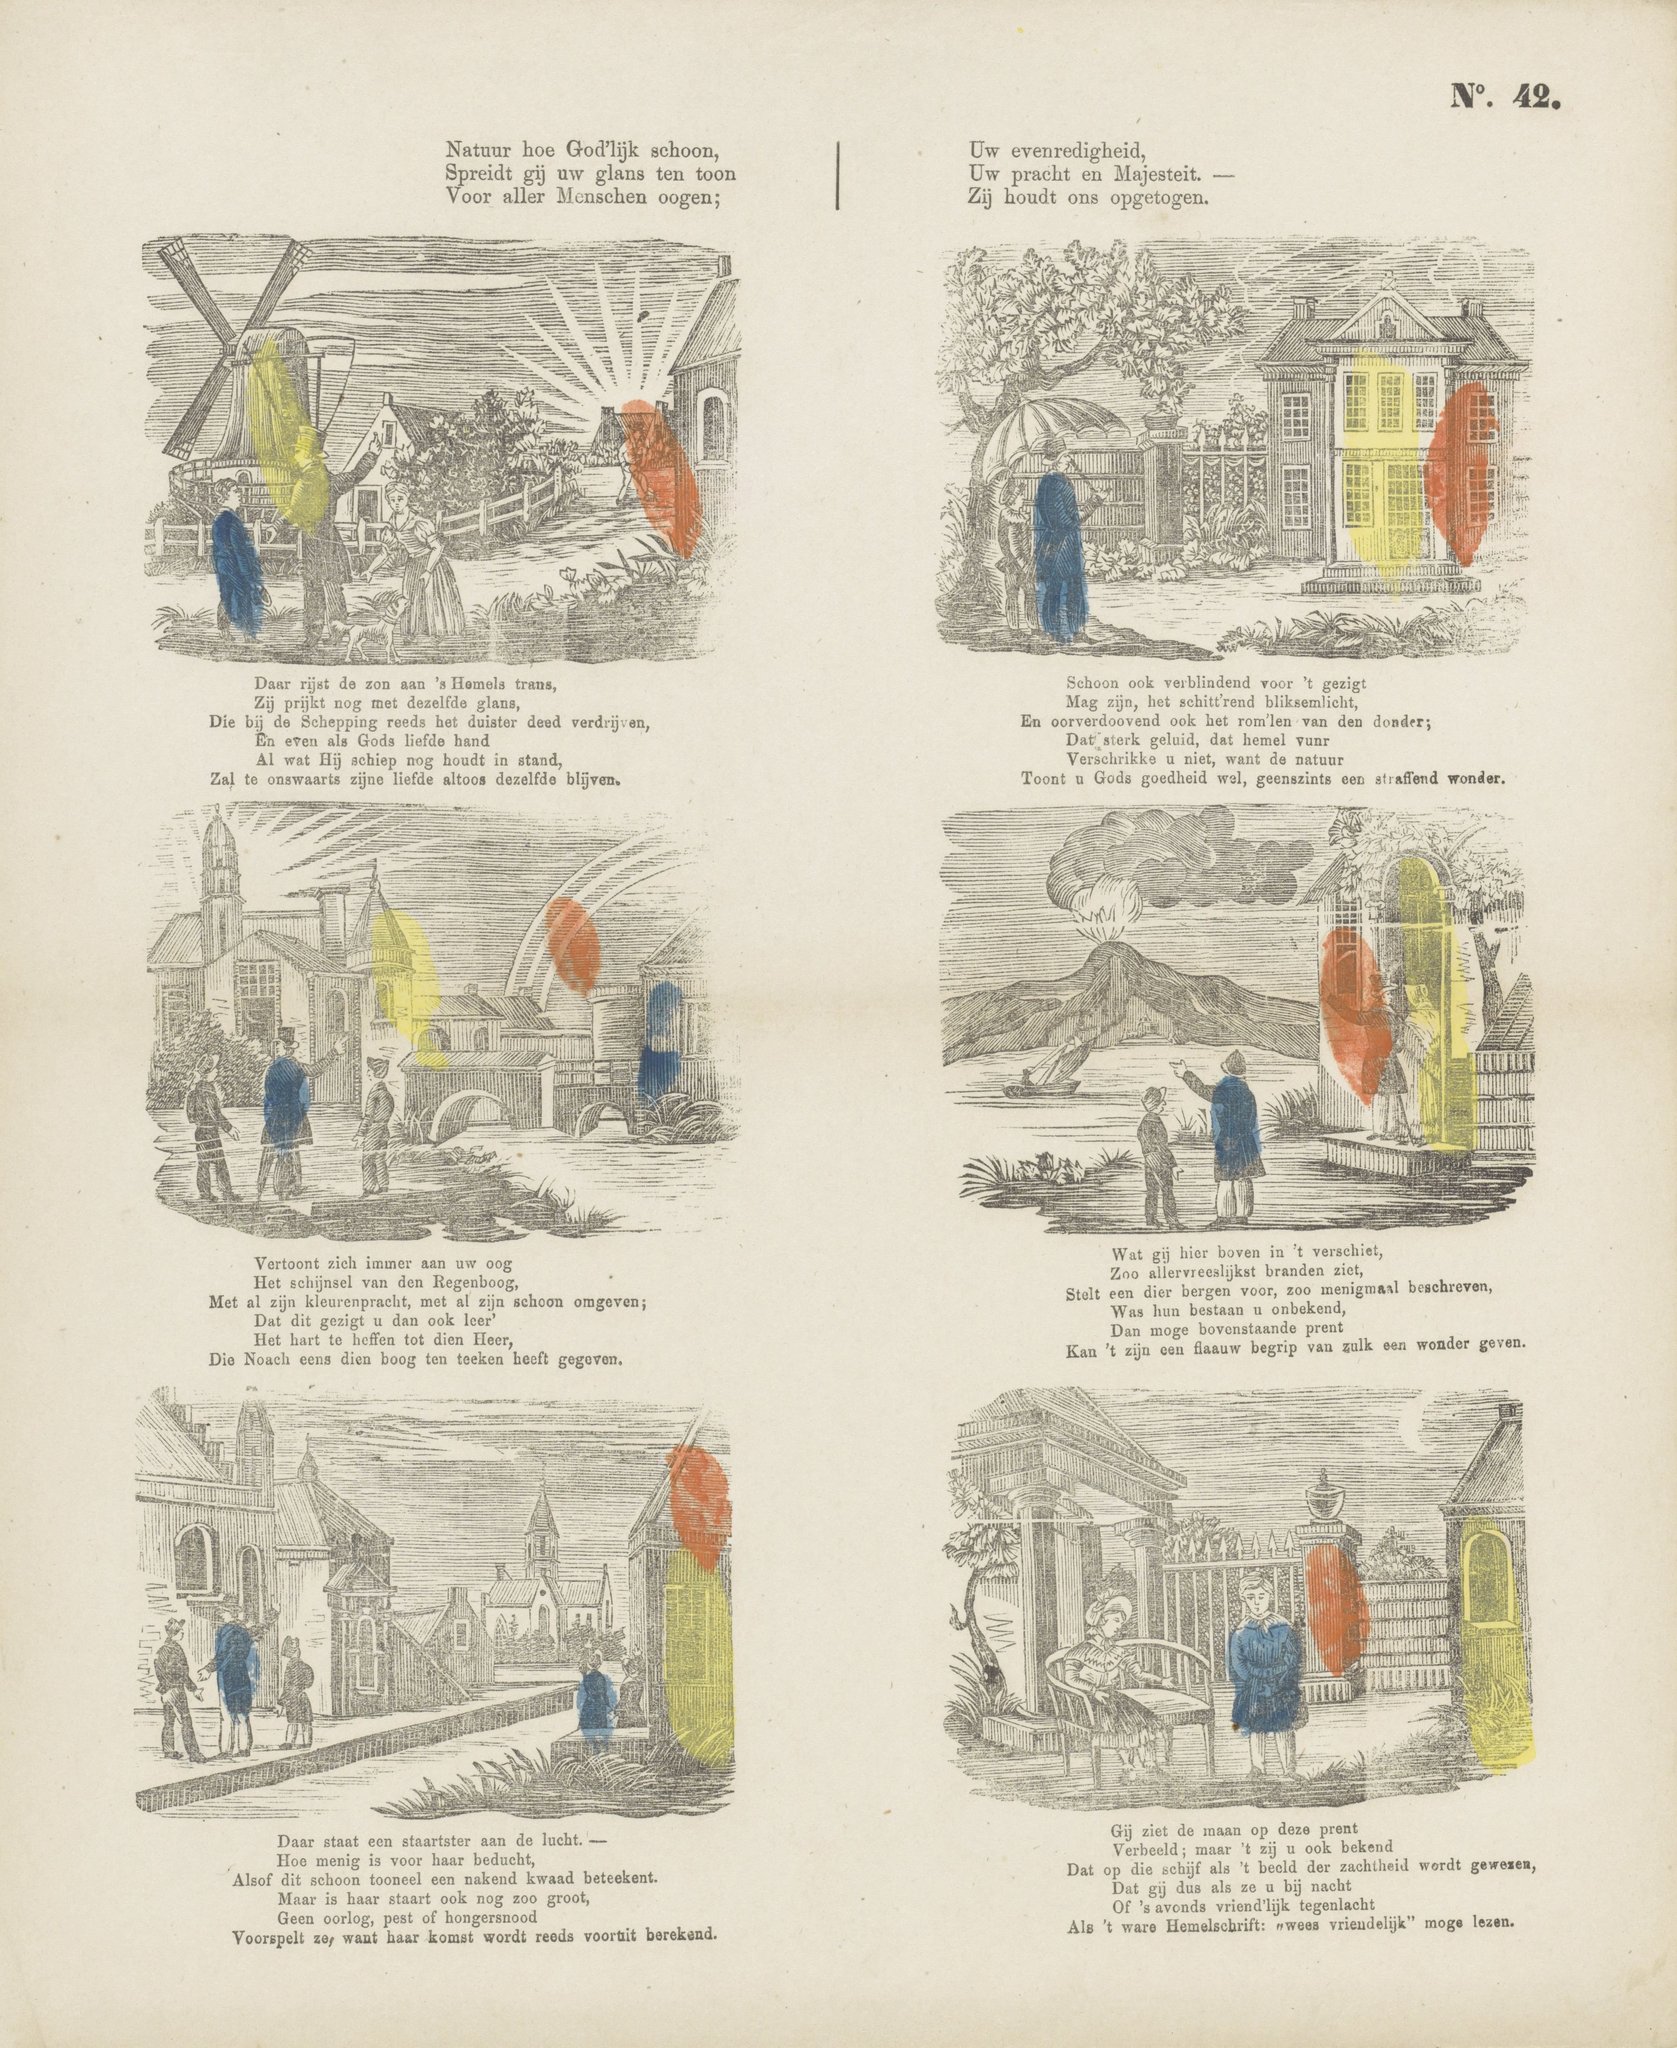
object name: print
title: Natuur hoe god'lijk schoon, / Spreidt gij uw glans ten toon / Voor aller menschen oogen; / Uw evenredigheid, / Uw pracht en majesteit. / Zij houdt ons opgetogen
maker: Anonymous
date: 1850-1870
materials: paper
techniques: colour, letterpress printing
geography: netherlands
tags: meteorological phenomena, thunderstorm, sunrise, eruption (of volcano), rainbow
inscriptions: collector's mark: Lugt 2760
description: Blad met 6 voorstellingen van natuurverschijnselen, zoals bliksem, een regenboog en een vulkaanuitbarsting. Onder elke afbeelding een zesregelig vers. Rechtsboven genummerd: No. 42.